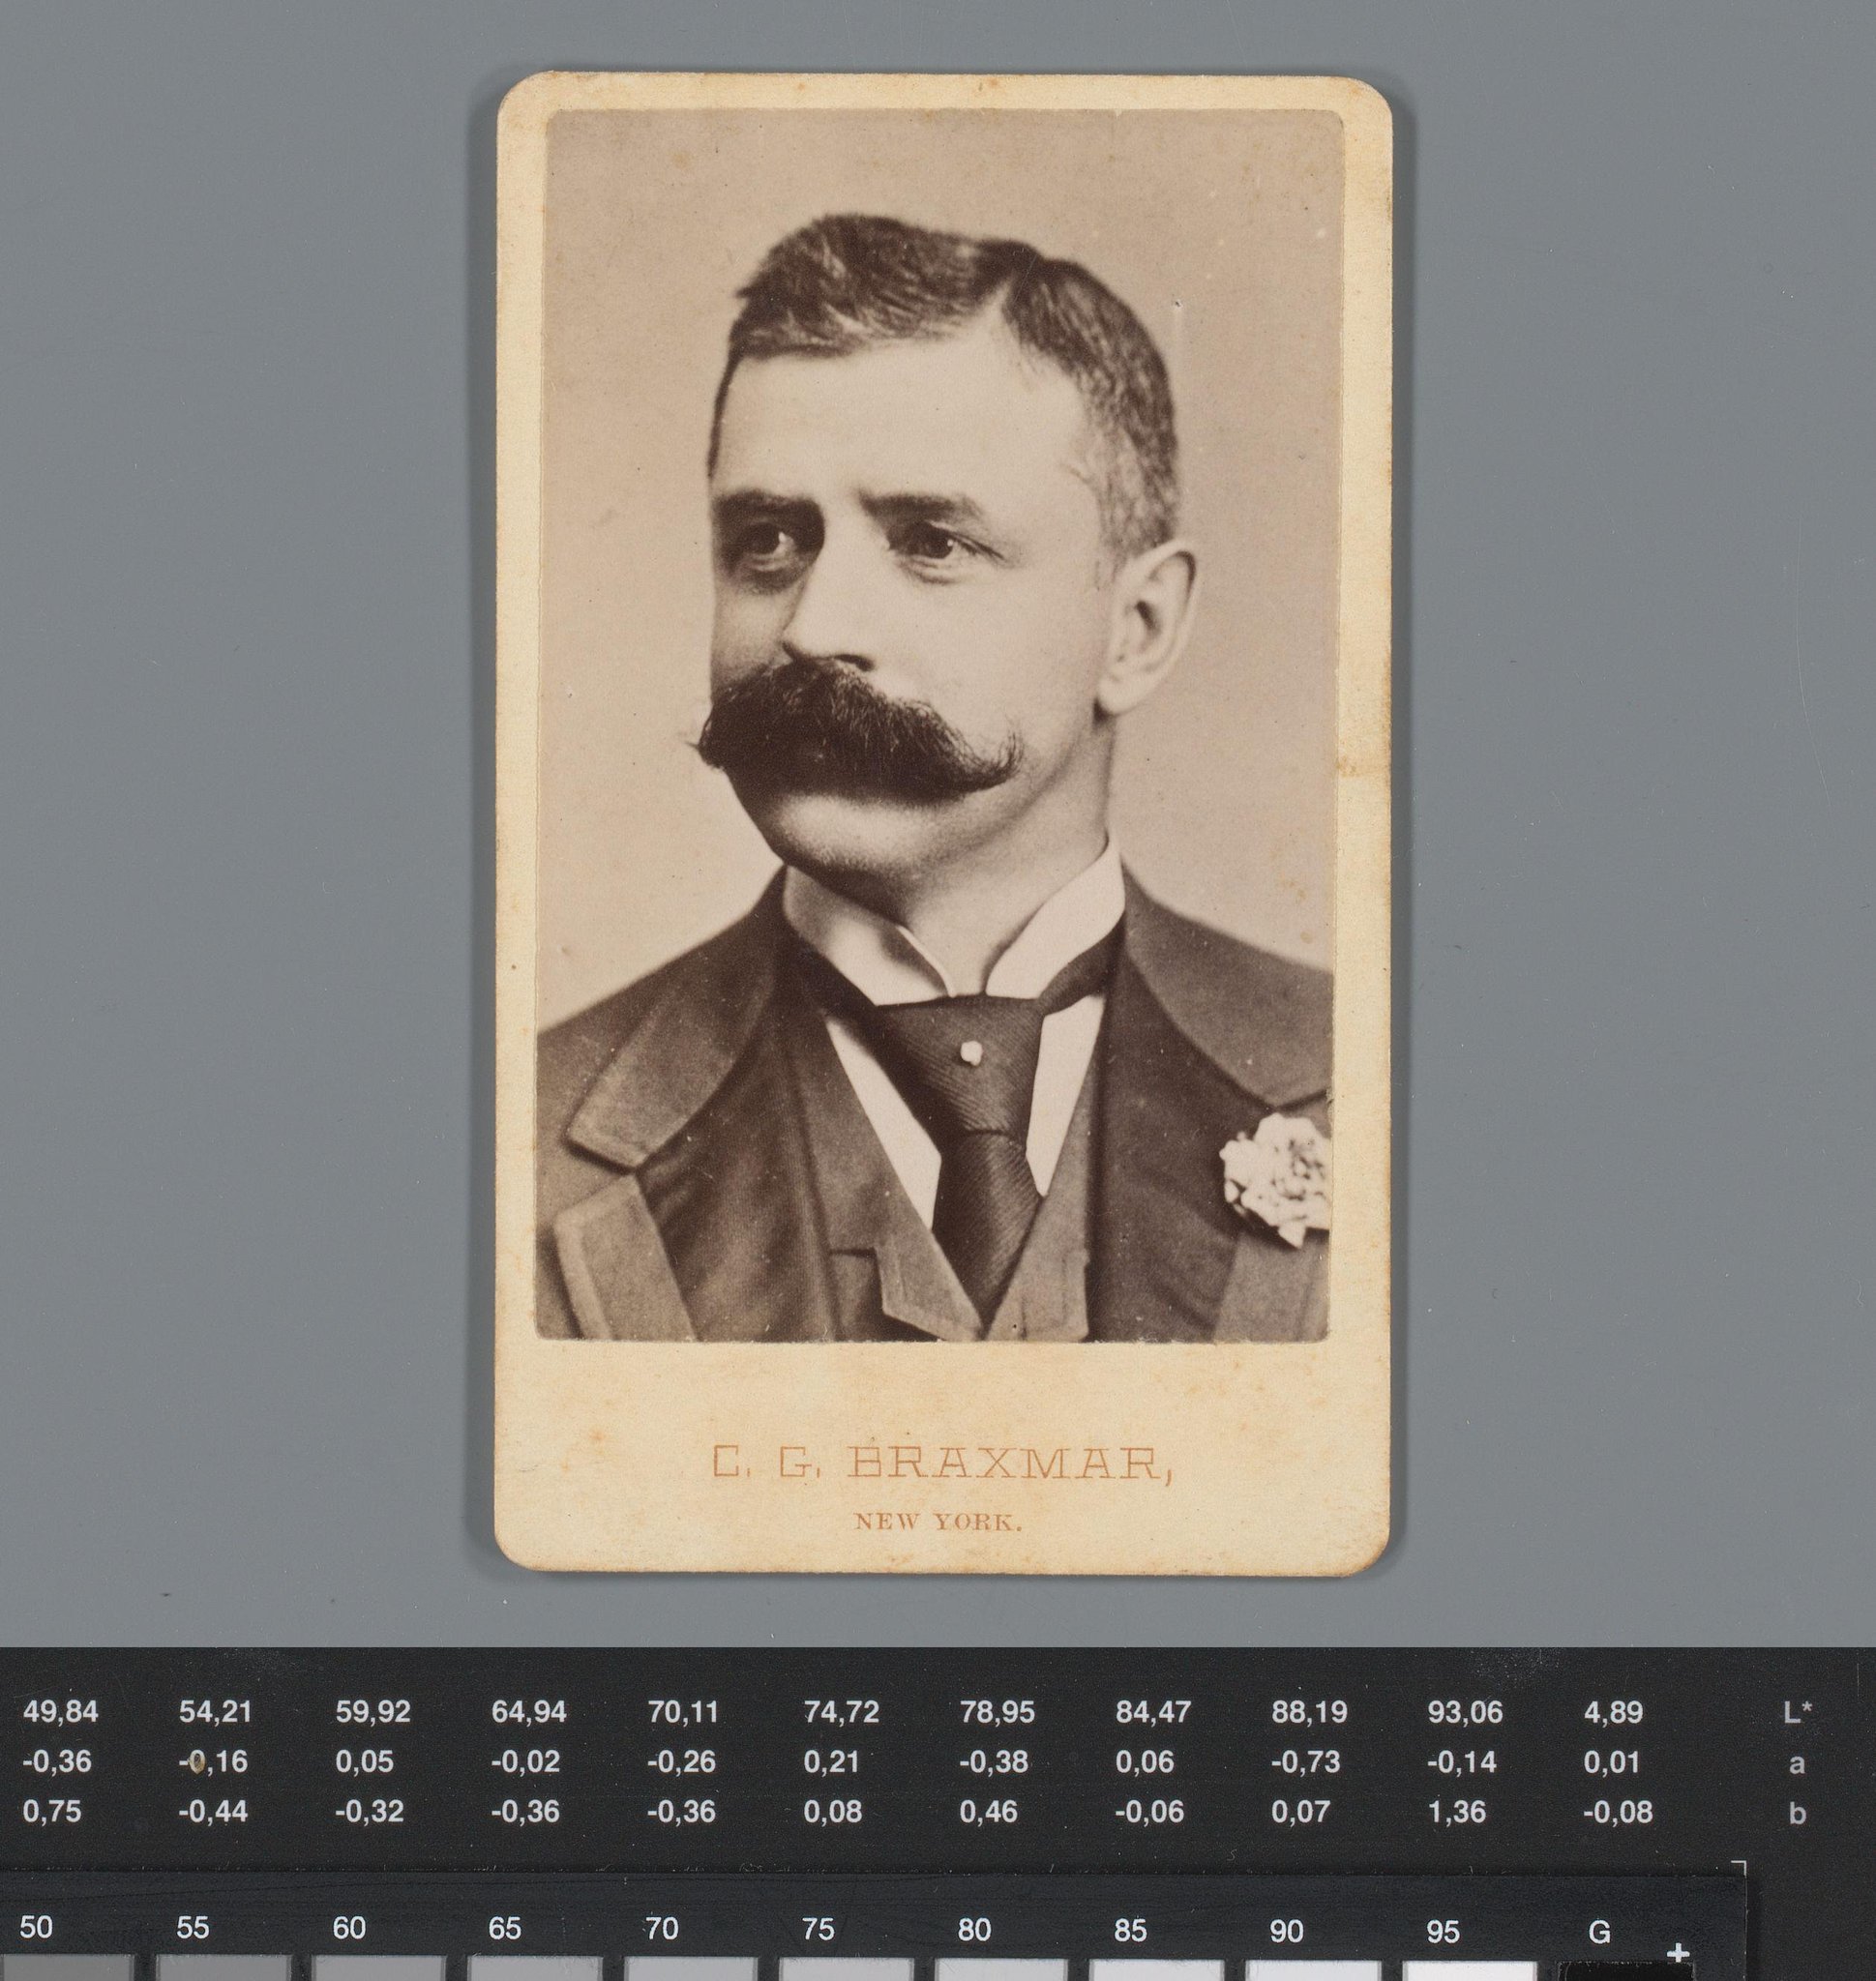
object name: photograph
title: Visitekaart voor juwelier Charles George Braxmar te New York met diens portret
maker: Anonymous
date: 1850-1915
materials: cardboard, photographic support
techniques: albumen print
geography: new york city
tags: advertising, historical persons, jeweller, goldsmith, silversmith, new york (city)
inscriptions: inscription: ‘C. G. BRAXMAR, / Manufacturing Jeweller, / Badges, Medals & Charms (...)’